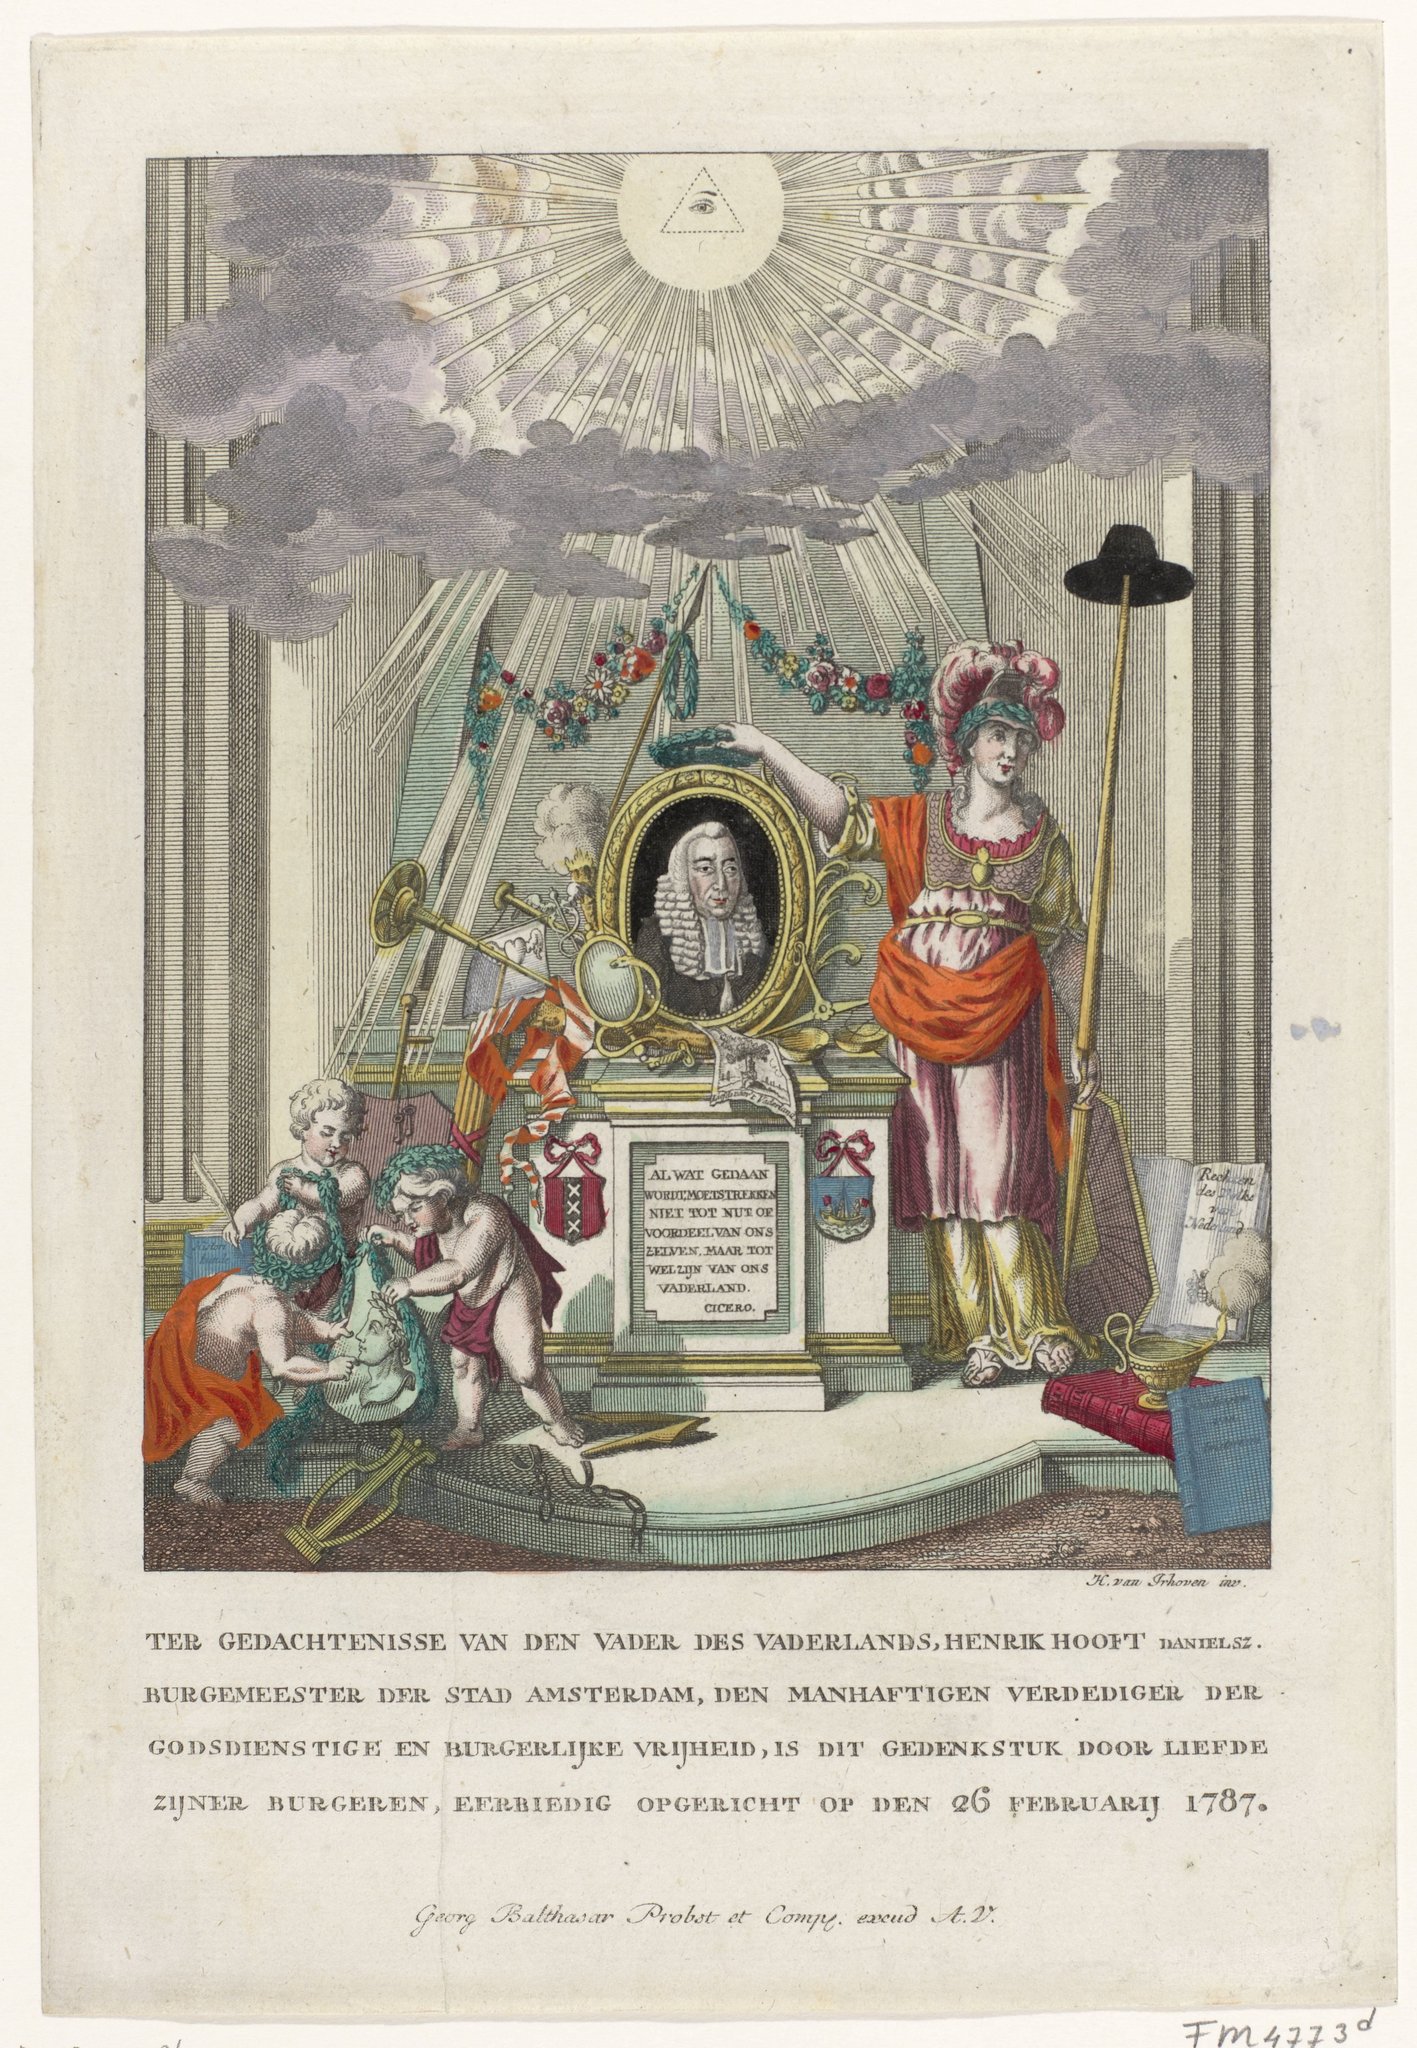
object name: print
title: Ter gedachtenissen van den vader des vaderlands, Henrik Hooft Danielsz. burgemeester der stad Amsterdam (...)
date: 1787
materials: paper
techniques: engraving, etching, hand coloring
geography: augsburg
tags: mayor, hendrik danielsz. hooft, the all-seeing eye, triangle with eye ~ symbol of god the father, freedom, liberty; 'libertà' (ripa) (+ abstract concept represented by female figure), amsterdam, patriots (1780-1795)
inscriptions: collector's mark: Lugt 2228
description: Allegorisch monument voor de Amsterdamse burgemeester Hendrik Danielsz. Hooft, naar aanleiding van zijn verdediging van de patriotse belangen in de raad op 26 februari 1787. Portretmedaillon op voetstuk, bekroond met krans door de Vrijheid, links omhangen drie putti eikenloof om het wapen van Hooft. Bovenaan het stralende Alziende Oog.